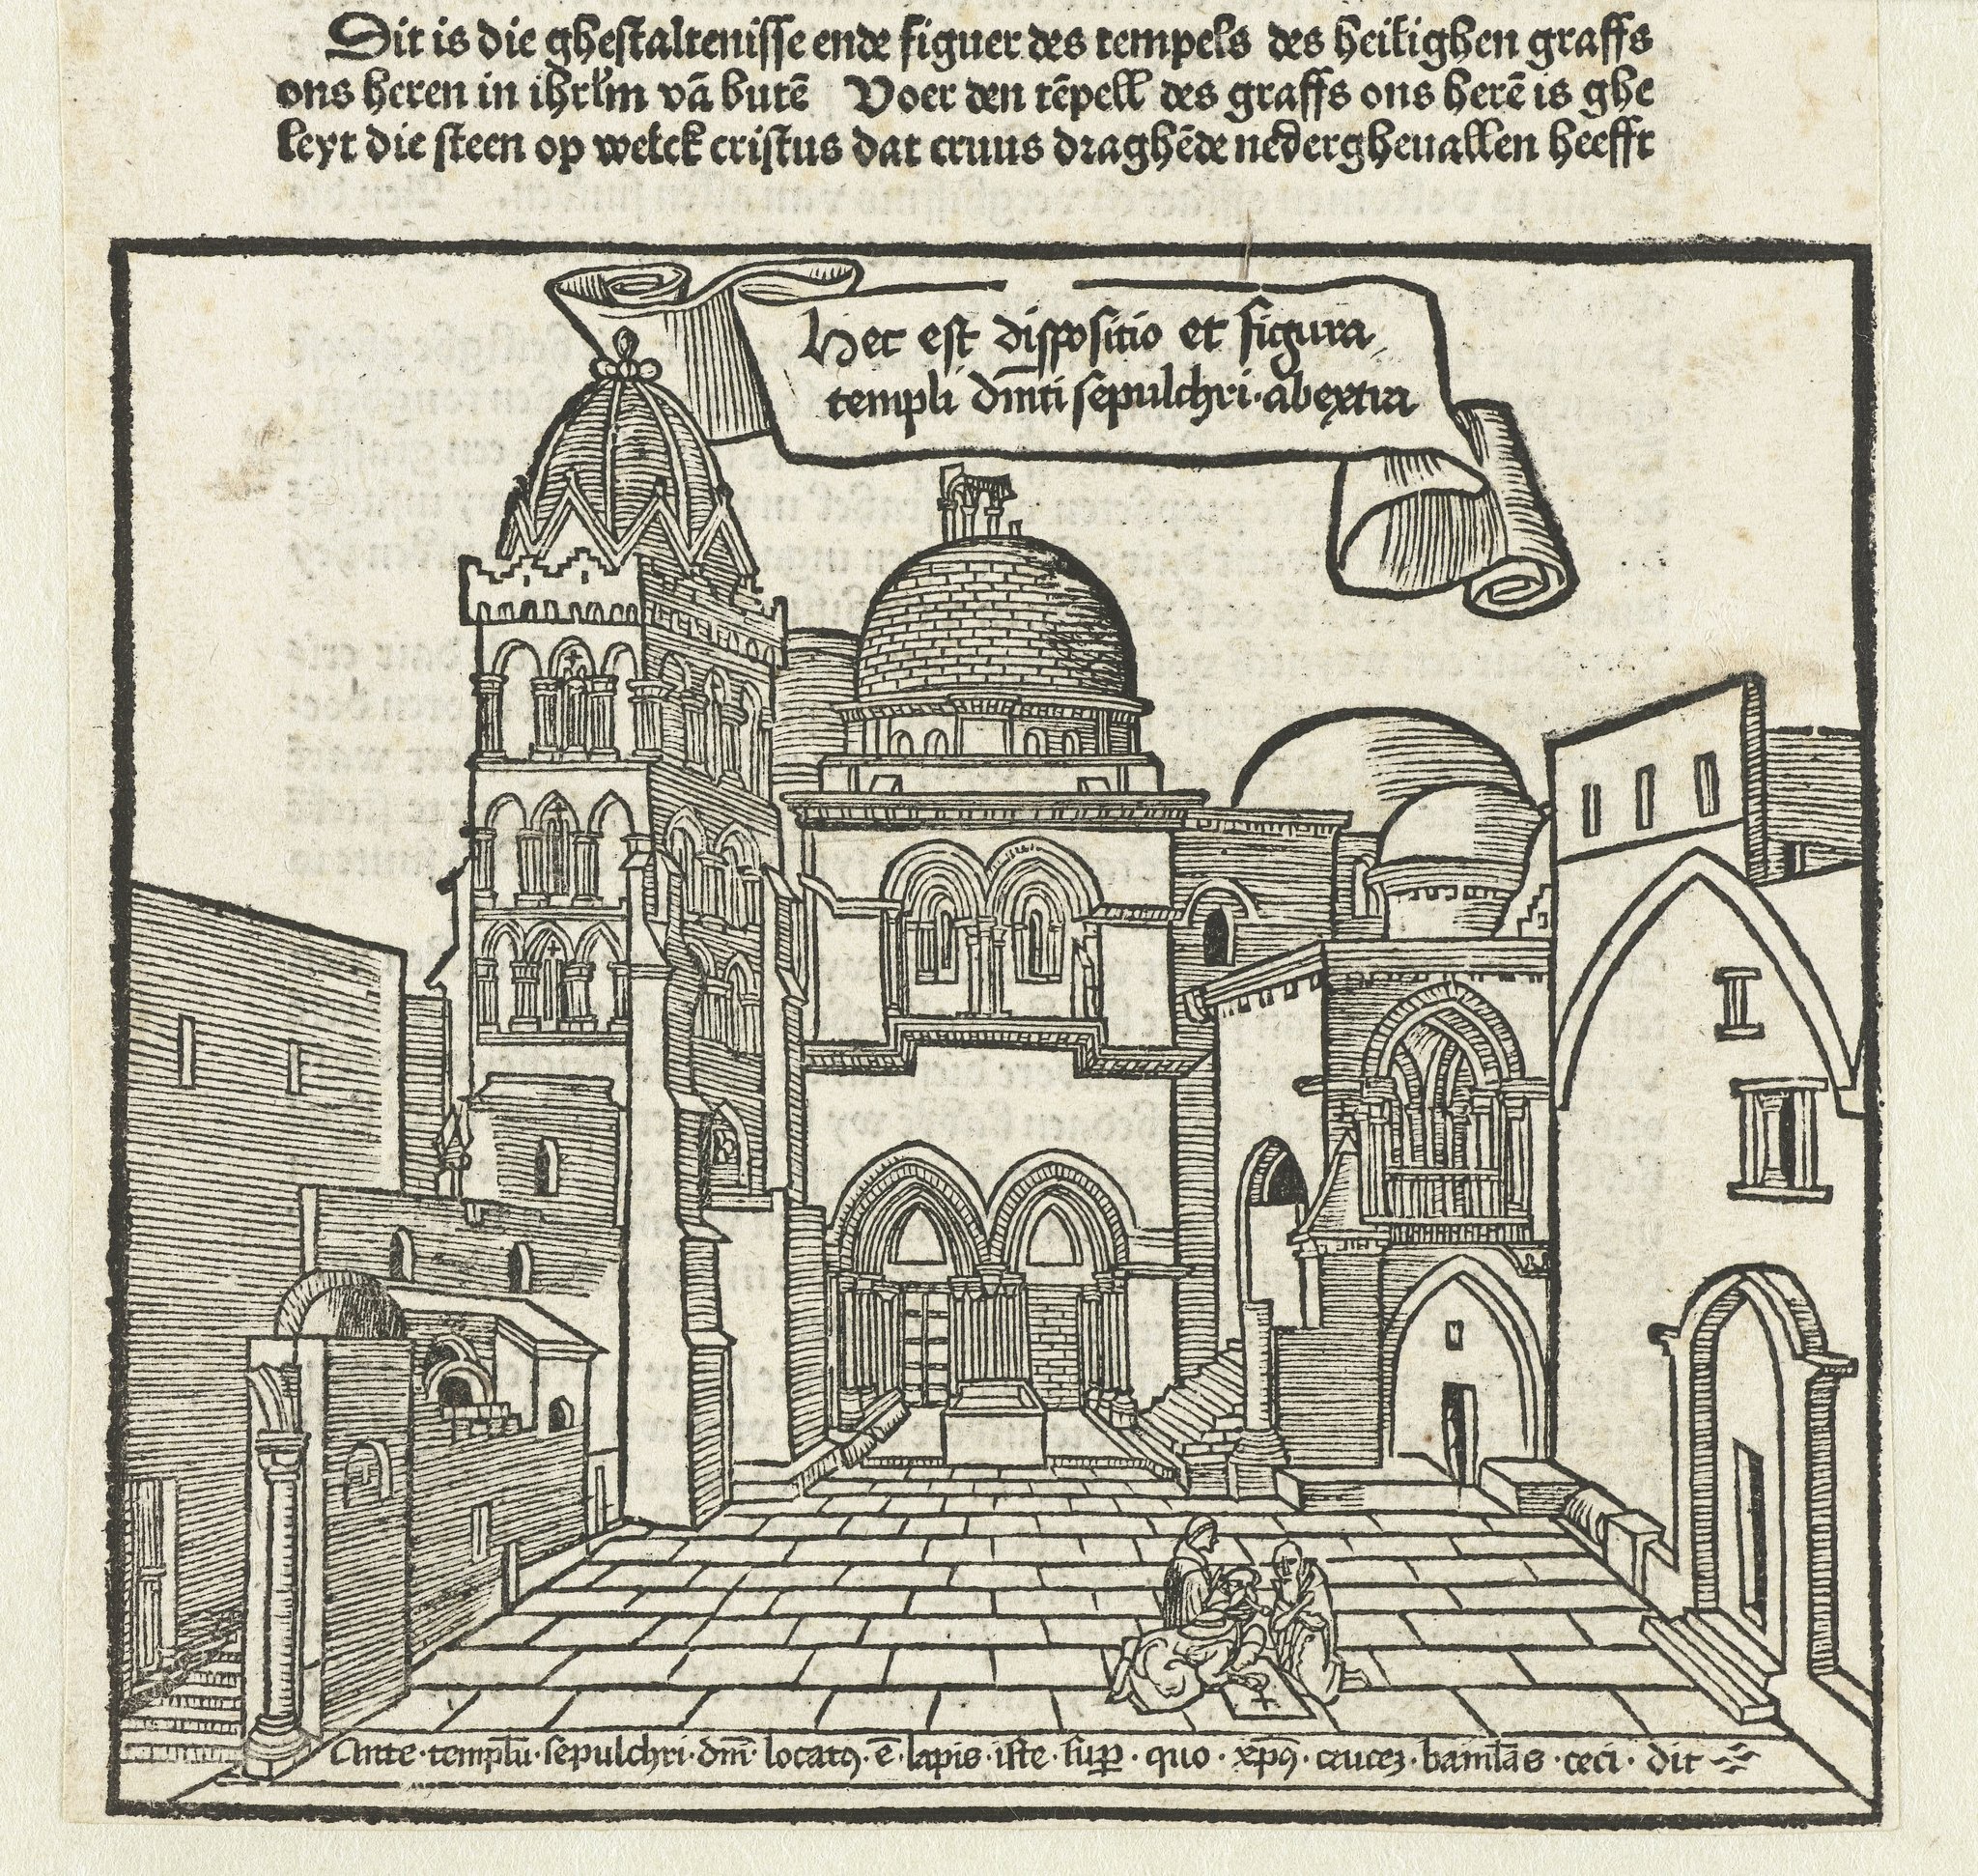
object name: book illustration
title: Tempel met graf van Christus in Jerusalem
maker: erhard reuwich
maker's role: painter, print maker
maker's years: 1445-1505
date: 1486-1488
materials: paper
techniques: woodcut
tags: place of pilgrimage, sacred place, church (exterior)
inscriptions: collector's mark: Lugt 2228, collector's mark: Lugt 698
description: Illustratie voor het boek van Bernhard von Breidenbach, Reise ins Heilige Land. De binnenplaats en de ingang van de Heilige Grafkerk in Jeruzalem, links van het ingangsportaal een klokkentoren. De kerk is gebouwd op de plek waar Christus gekruisigd zou zijn en het graf van Christus zich zou bevinden, en is daarom een belangrijk pelgrimsoord. Op het voorplein zitten vier pelgrims bij een steen met een kruis erop, deze markeert een punt uit de kruisweg van Christus. Onderaan een regel tekst en boven de kerk een banderol met tekst in het Latijn. Boven de prent een drieregelige tekst in het Nederlands.